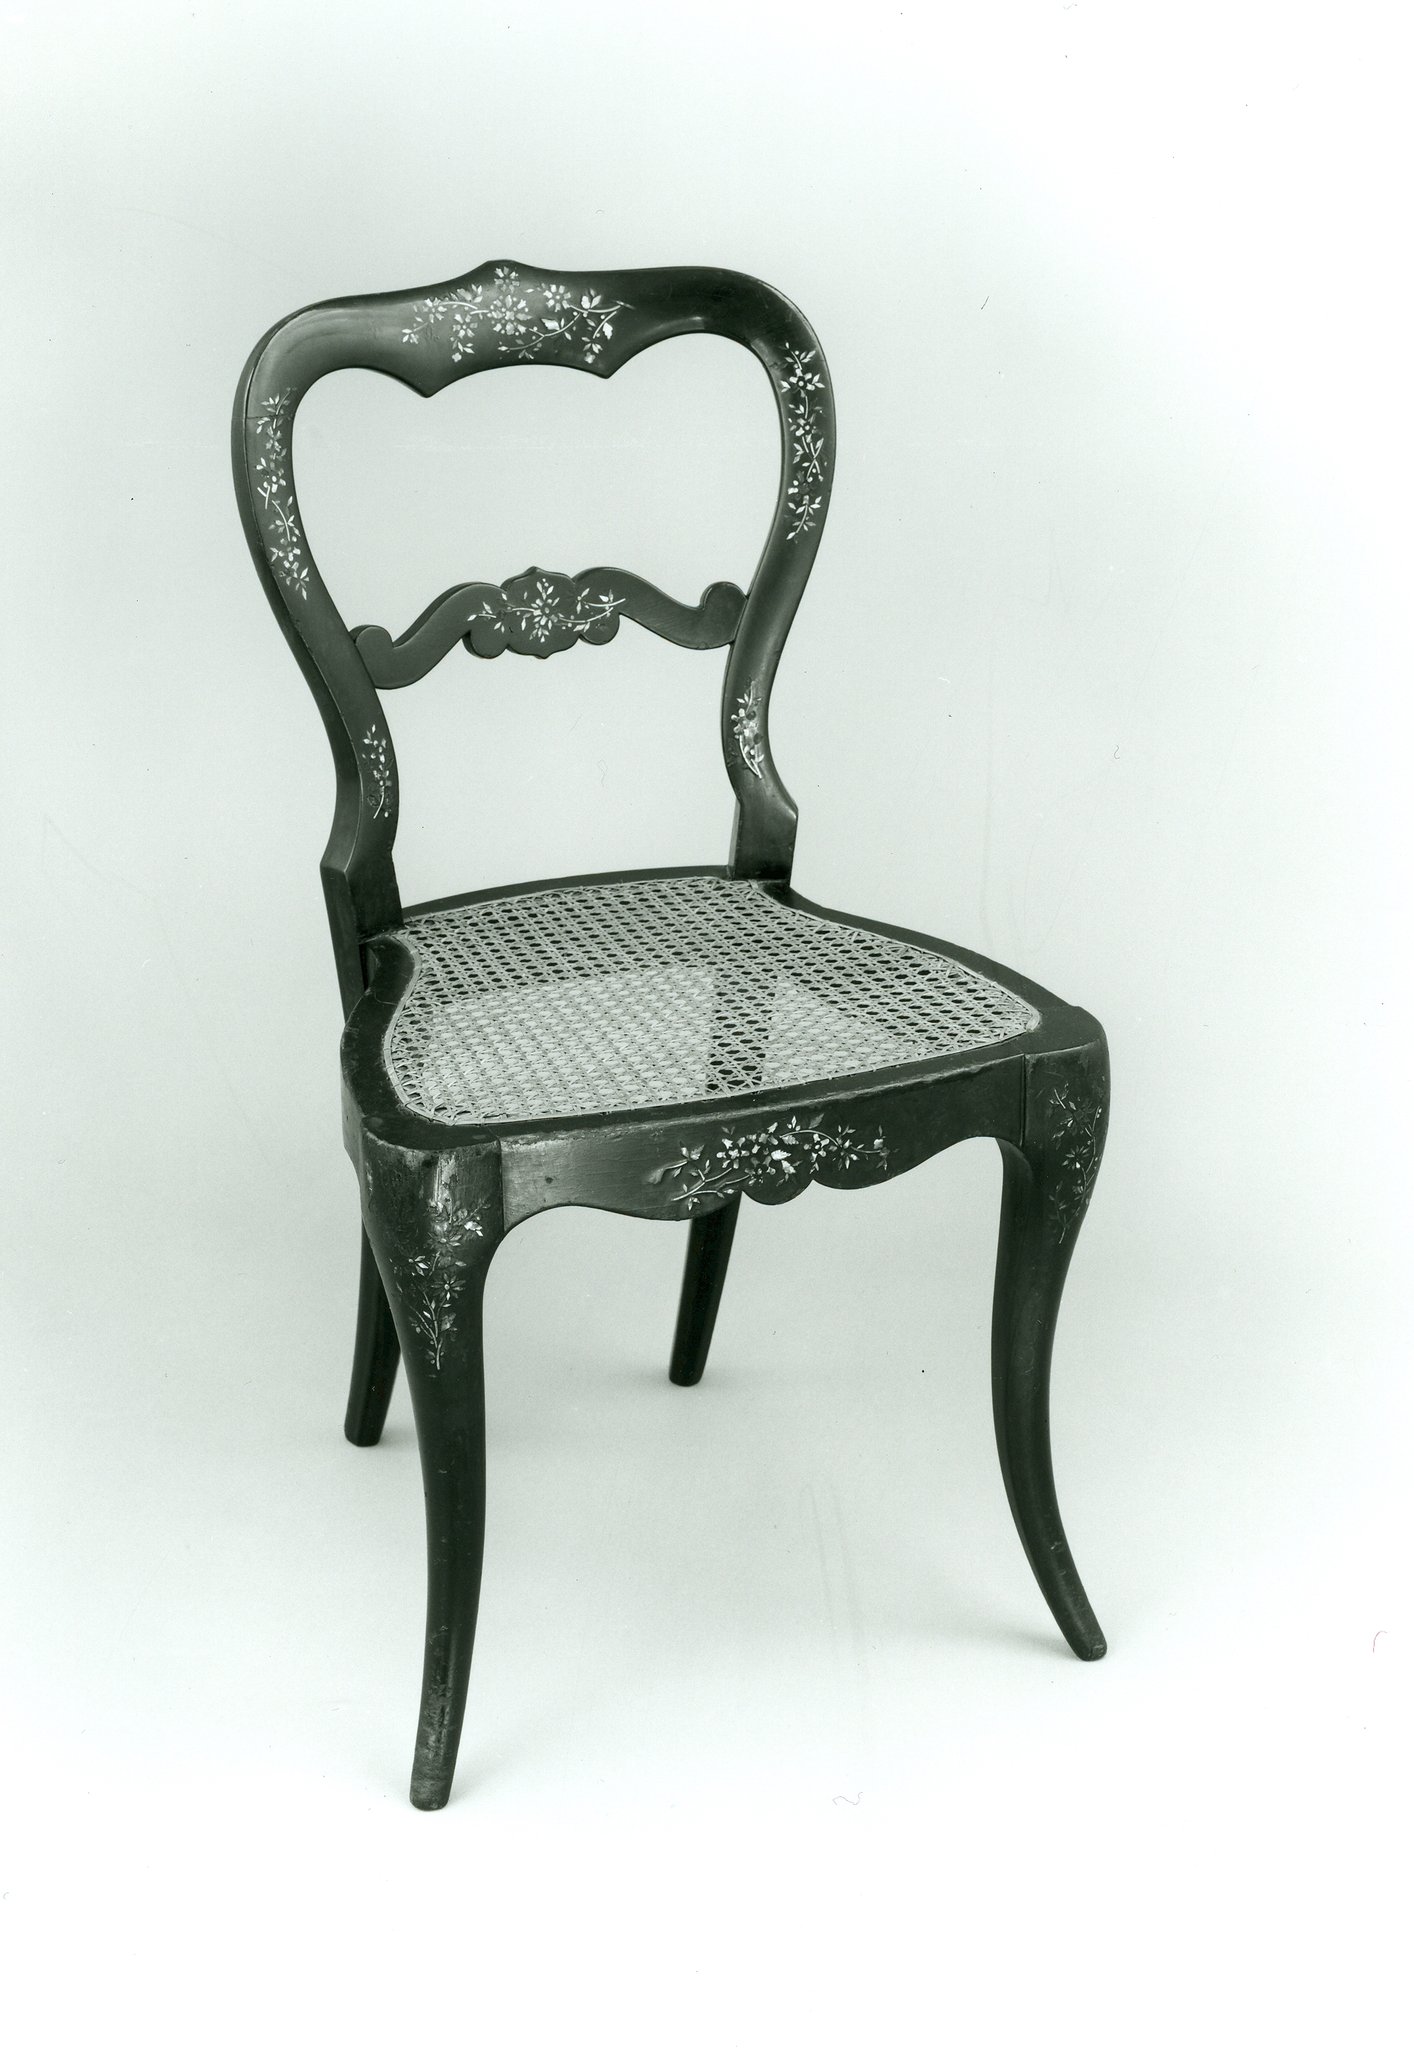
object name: chair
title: Papier-mâchè side chair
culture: british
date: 1830-1860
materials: lacquer, mother of pearl, paper, wood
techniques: caning, gilding, painting